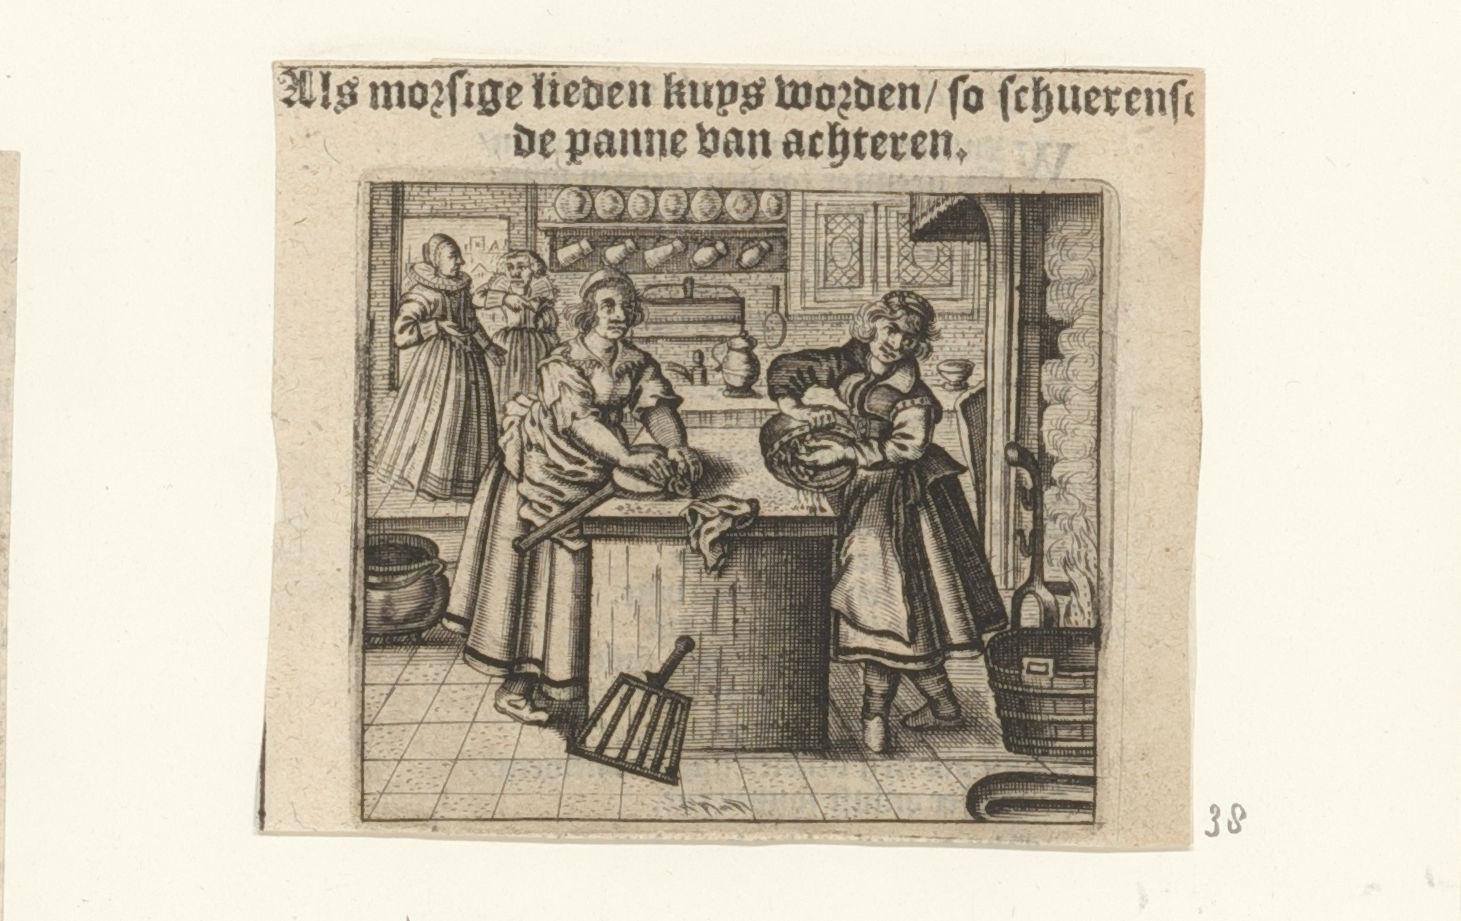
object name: book illustration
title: Als morsige lieden kuys worden / so schueren se de pannen van achteren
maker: Anonymous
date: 1635-1715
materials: paper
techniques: engraving, letterpress printing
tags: kitchen, proverbs, sayings, etc., kitchen-maid, kitchen servant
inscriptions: collector's mark: Lugt 1641, stamp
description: Veel versies van dit embleem verschenen in verschillende uitgave van Spiegel van den Ouden ende Nieuwen Tydt. Zoals: Cats, Jacob. Spiegel van den Ouden ende Nieuwen-tijt, Bestaende uyt Spreeck-woorden (...). Dordrecht: Jacob Braat, 1647. Maar ook in andere publicaties (1665, 1671, 1715, 1722).